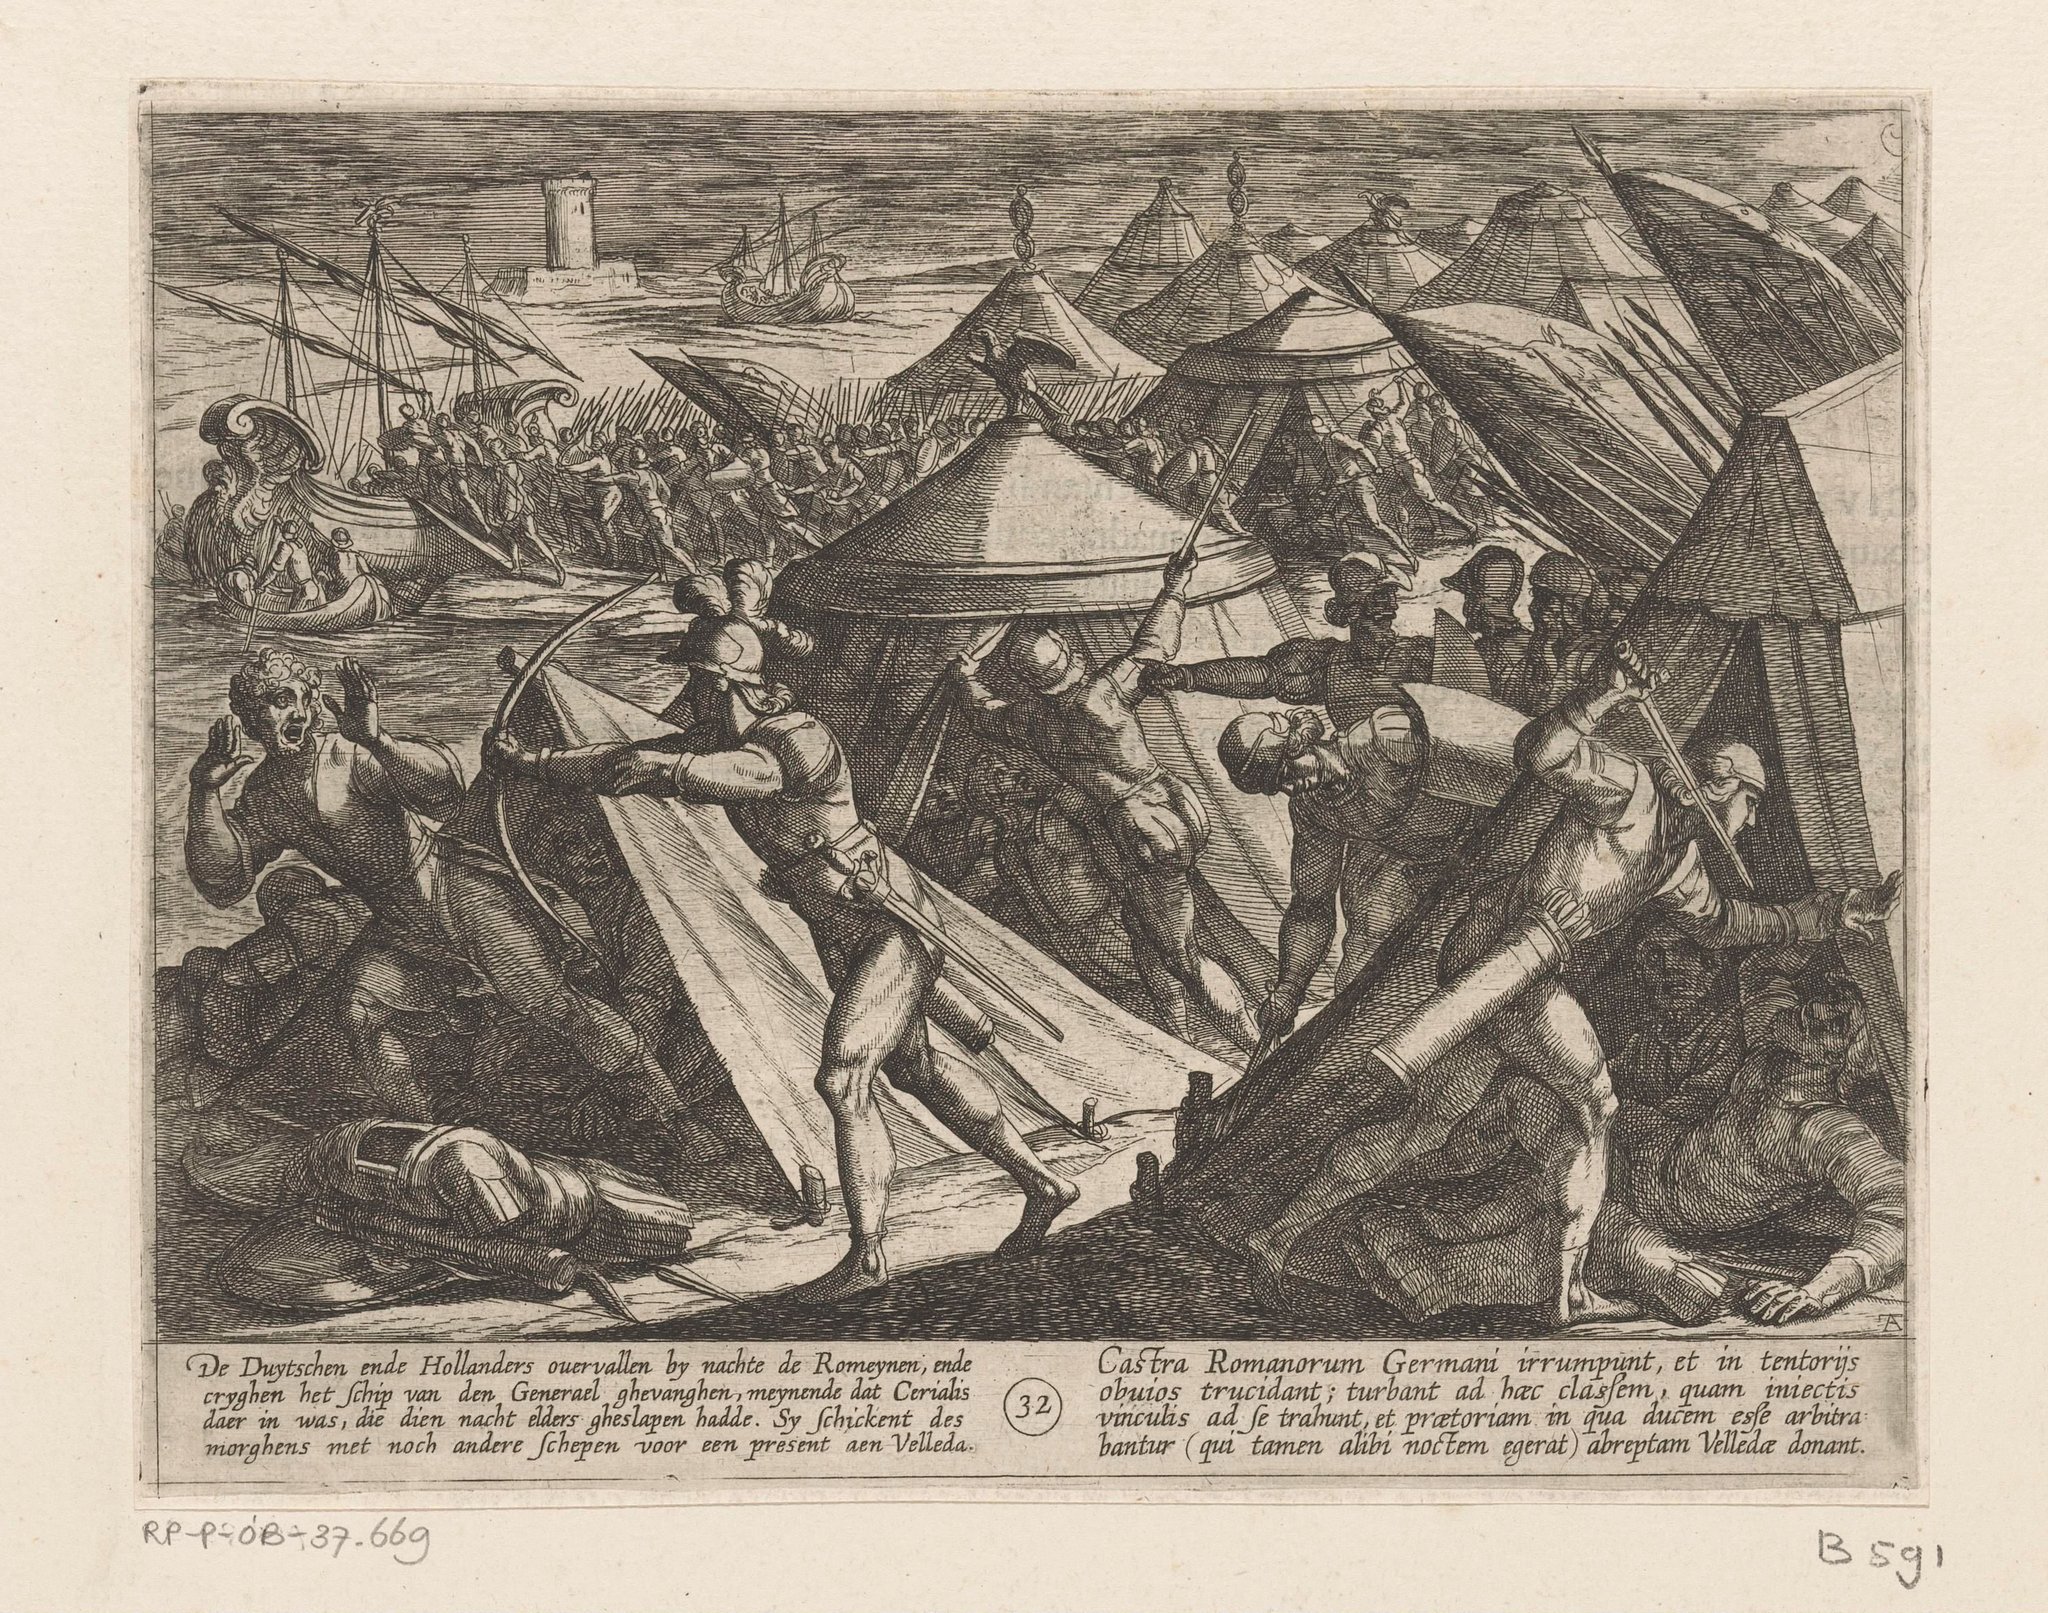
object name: print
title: De Bataafse oorlogen tegen de Romeinen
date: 1611-1612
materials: paper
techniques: etching, letterpress printing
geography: antwerp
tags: battle, the soldier; the soldier's life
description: Nederlanders en Duitsers vallen samen het Romeinse kamp aan en veroveren de boot van Cerialis. Onderschrift in het Nederlands en in het Latijn.